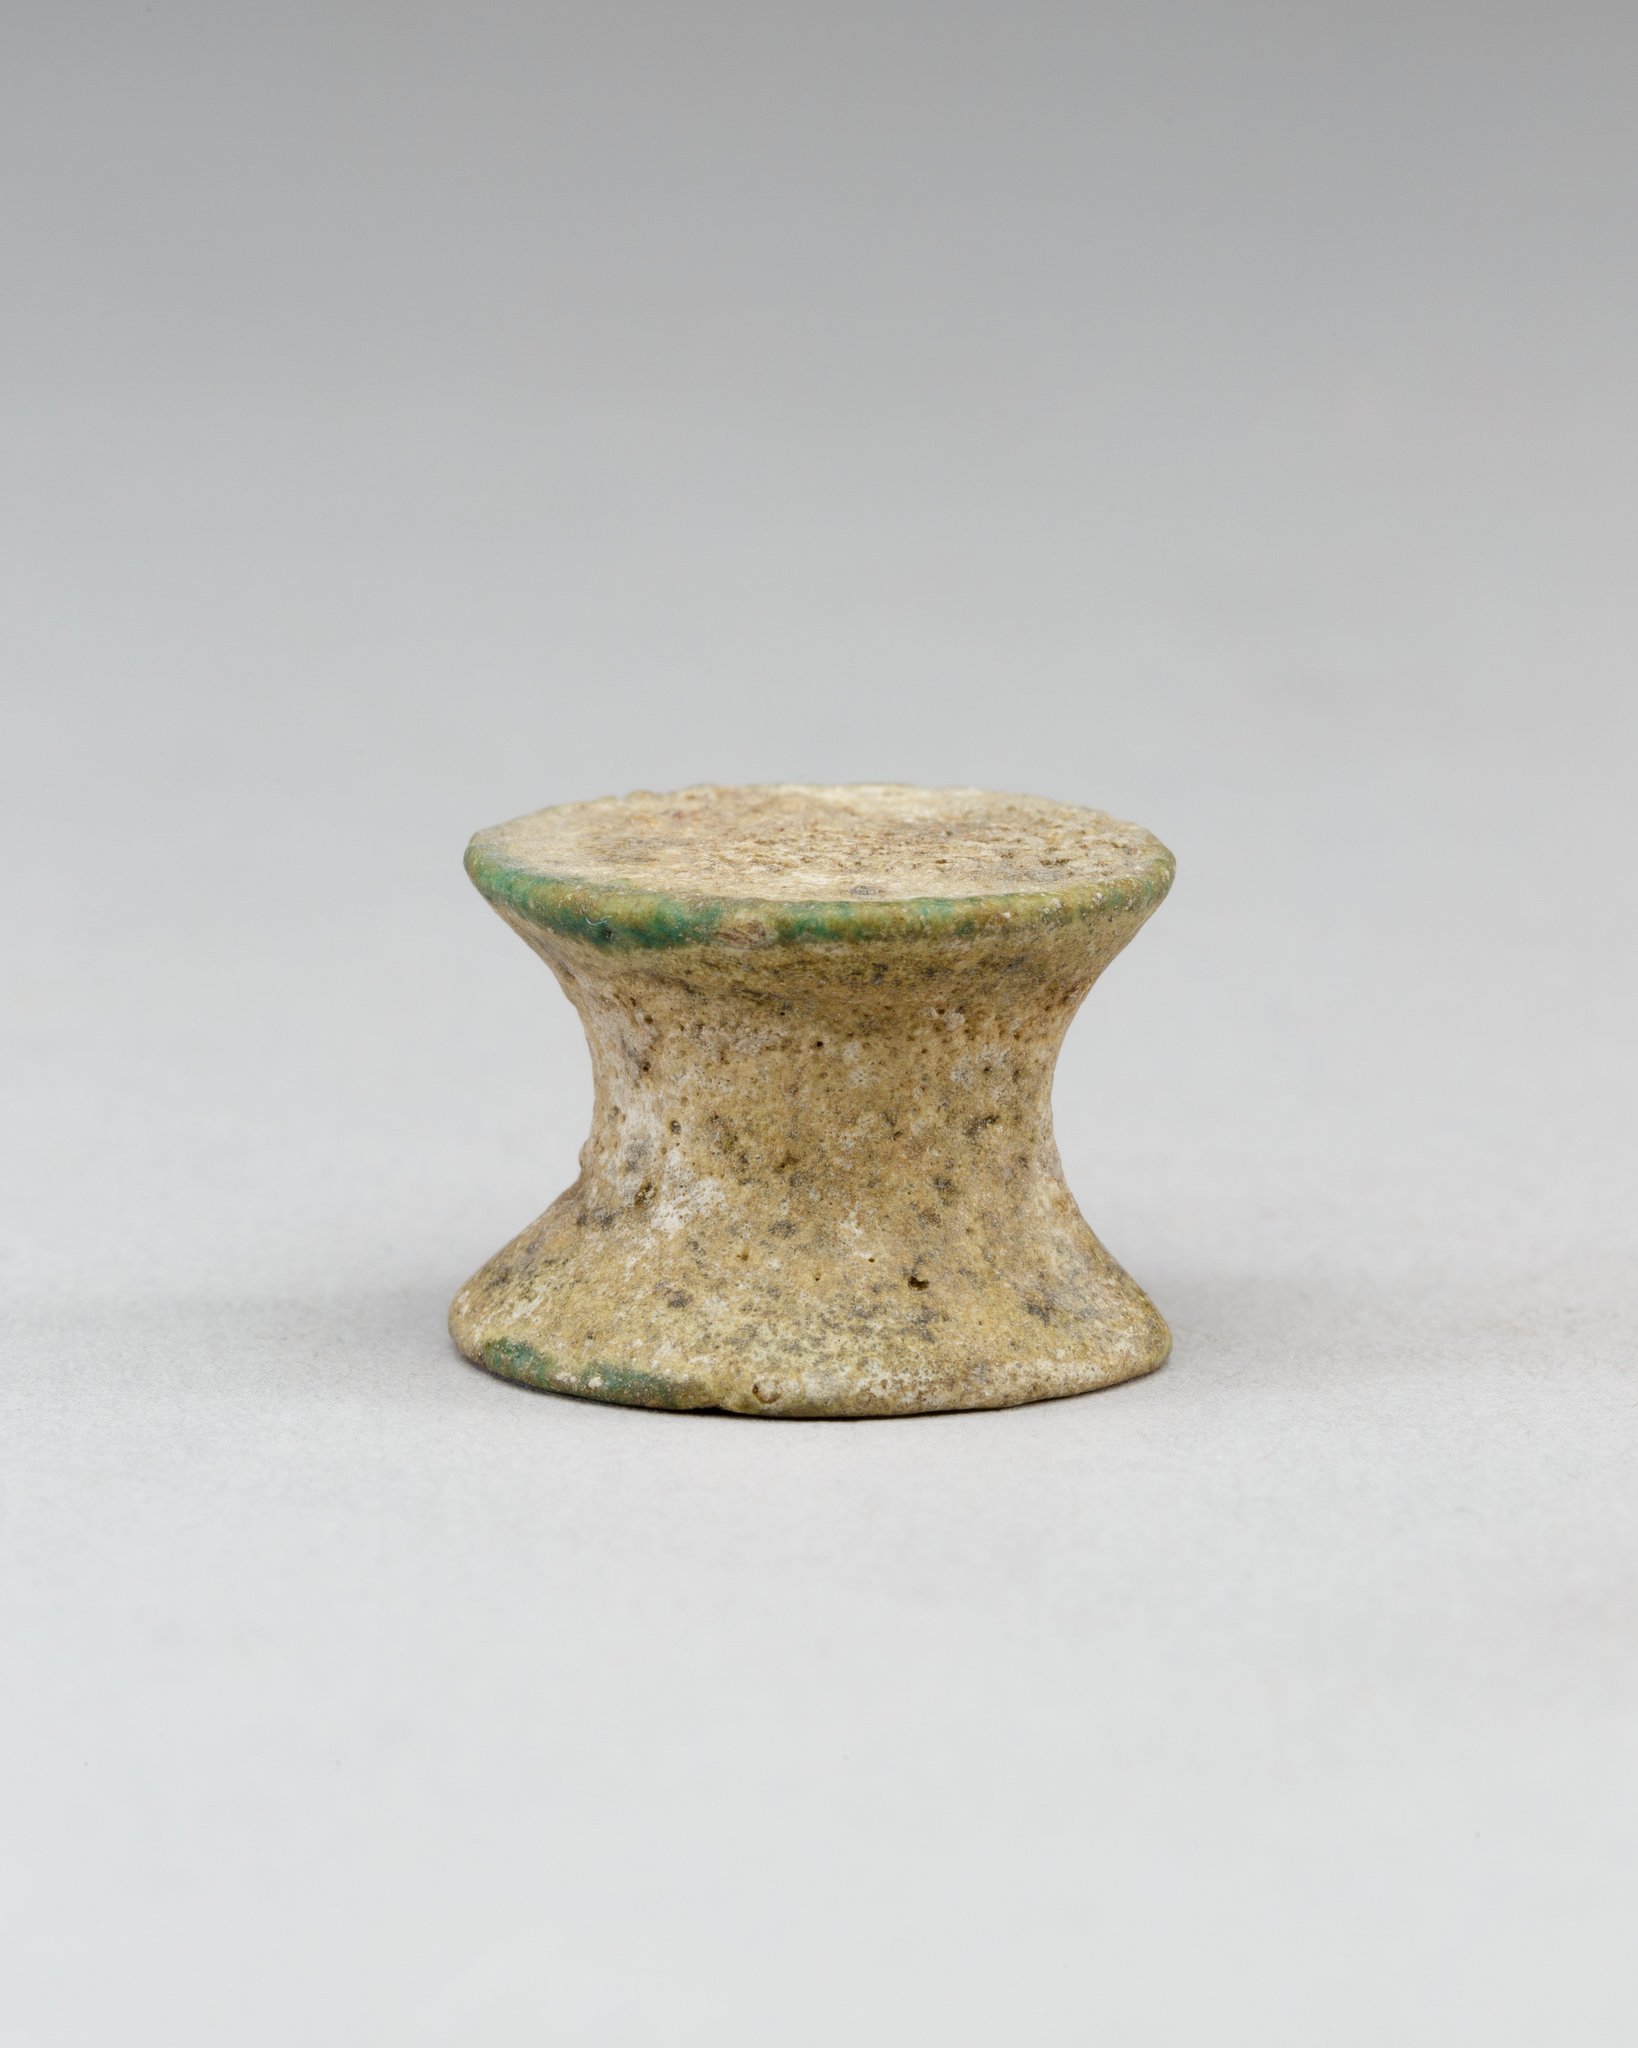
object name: game piece, spool, burial 8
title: Spool-Shaped Gaming Piece, Tomb of Neferkhawet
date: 1504-1447 BCE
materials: faience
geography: egypt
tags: games